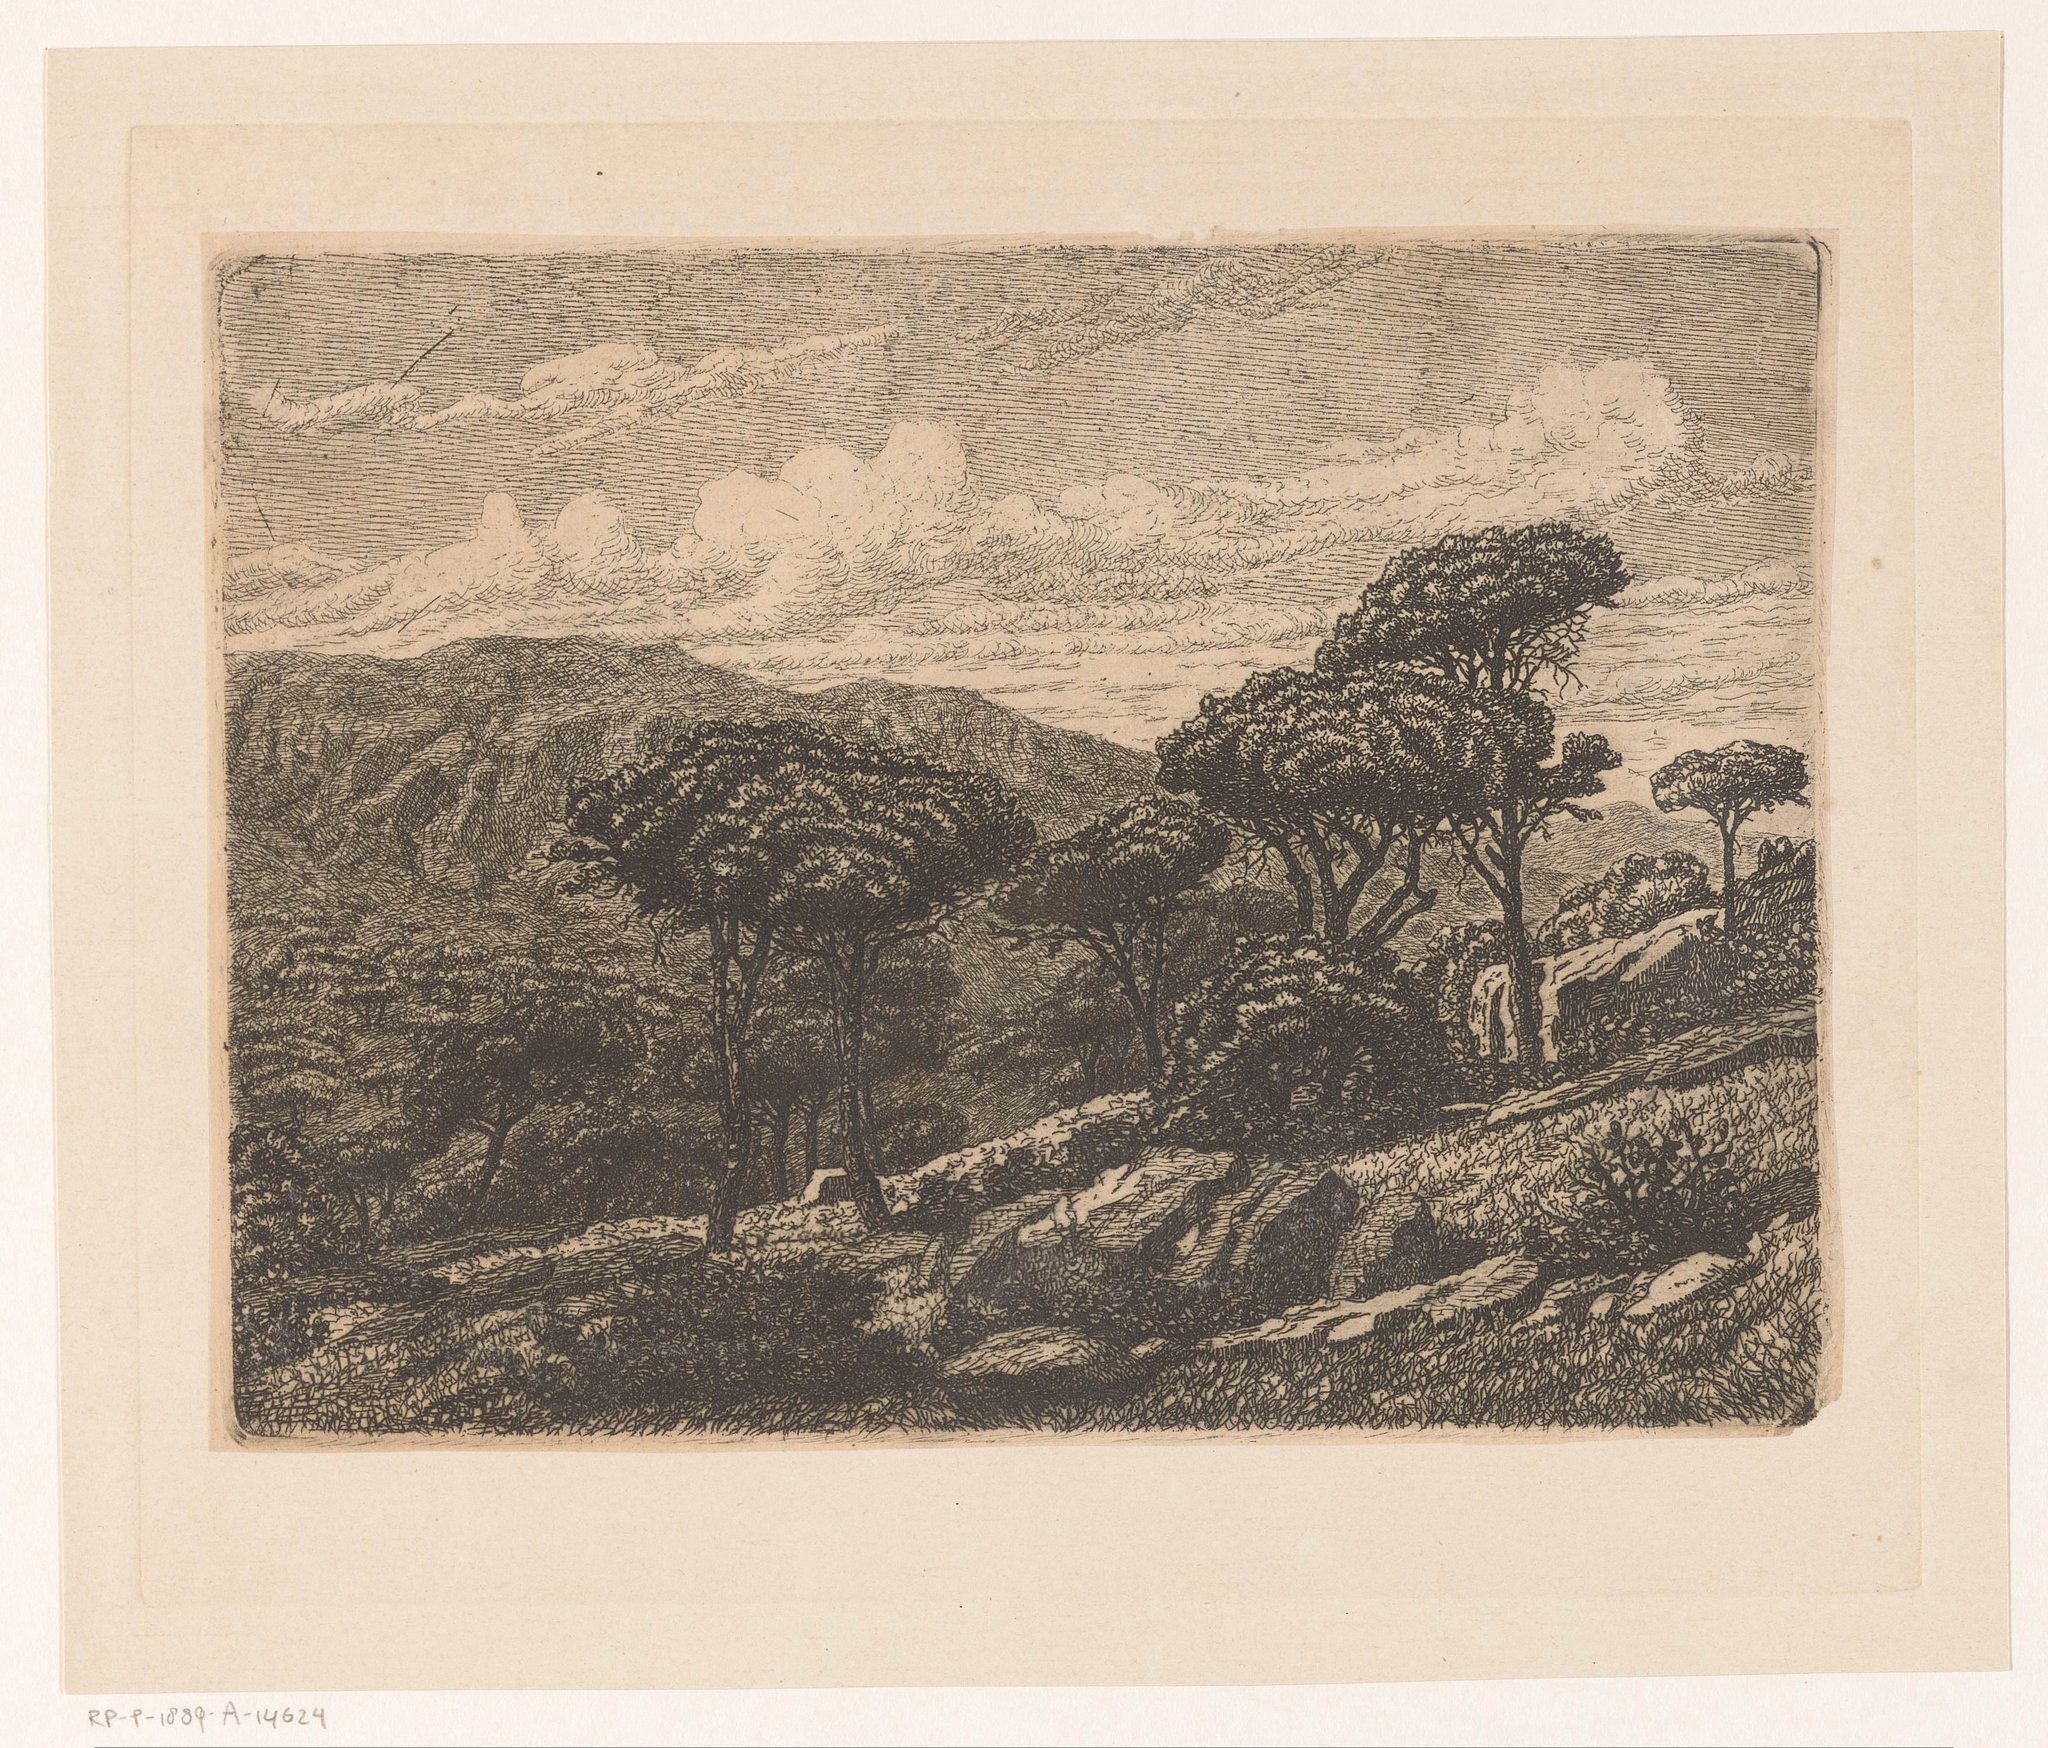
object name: print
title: Bergachtig landschap met bomen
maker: agustín riancho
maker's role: painter, print maker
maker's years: 1841-1929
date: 1851-1889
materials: paper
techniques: etching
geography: spain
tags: landscapes, mountains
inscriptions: collector's mark: Lugt 1485, collector's mark: Lugt 2228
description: Gezicht op een bergachtig landschap met hoge bomen op de voorgrond.